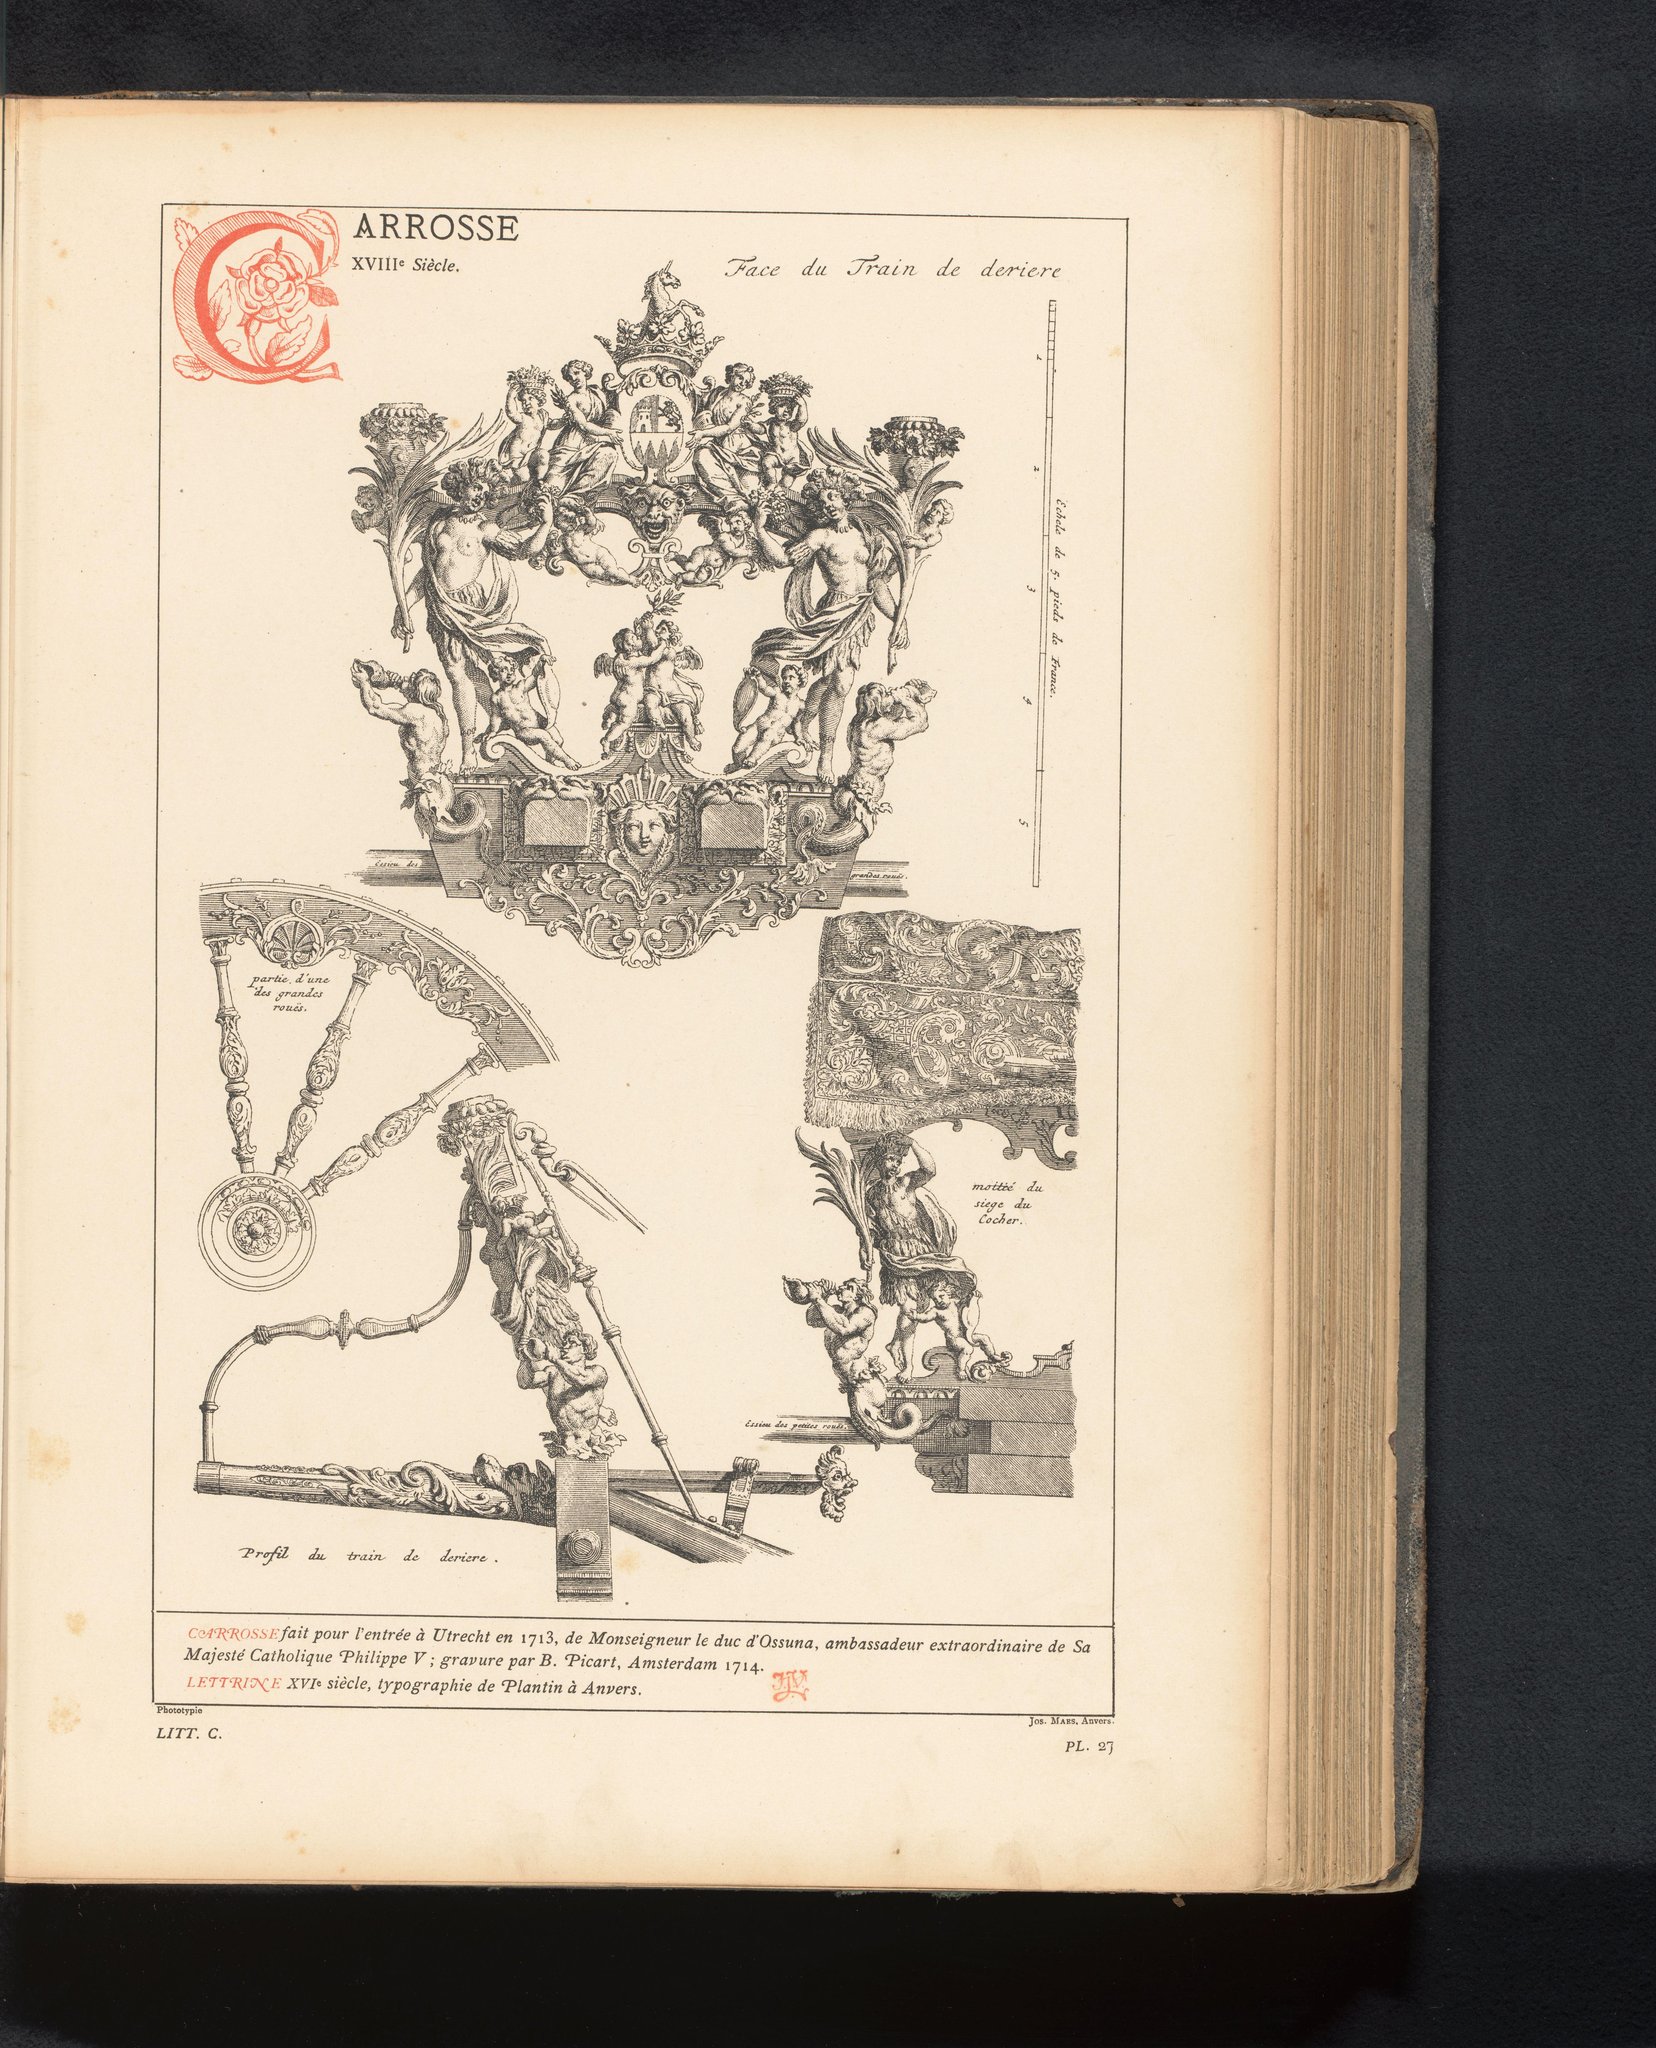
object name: page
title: Reproductie van een prent met details van de koets van Filips V van Spanje tijdens zijn intocht in Utrecht in 1713 door Bernard Picart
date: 1875-1880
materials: paper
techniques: photolithography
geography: antwerp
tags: four-wheeled, animal-drawn vehicle, e.g.: cab, carriage, coach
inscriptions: inscription: ‘Carosse fait pour (...)’, monogram: ‘JJvY’, inscription: ‘LITT: C. - PL. 27’